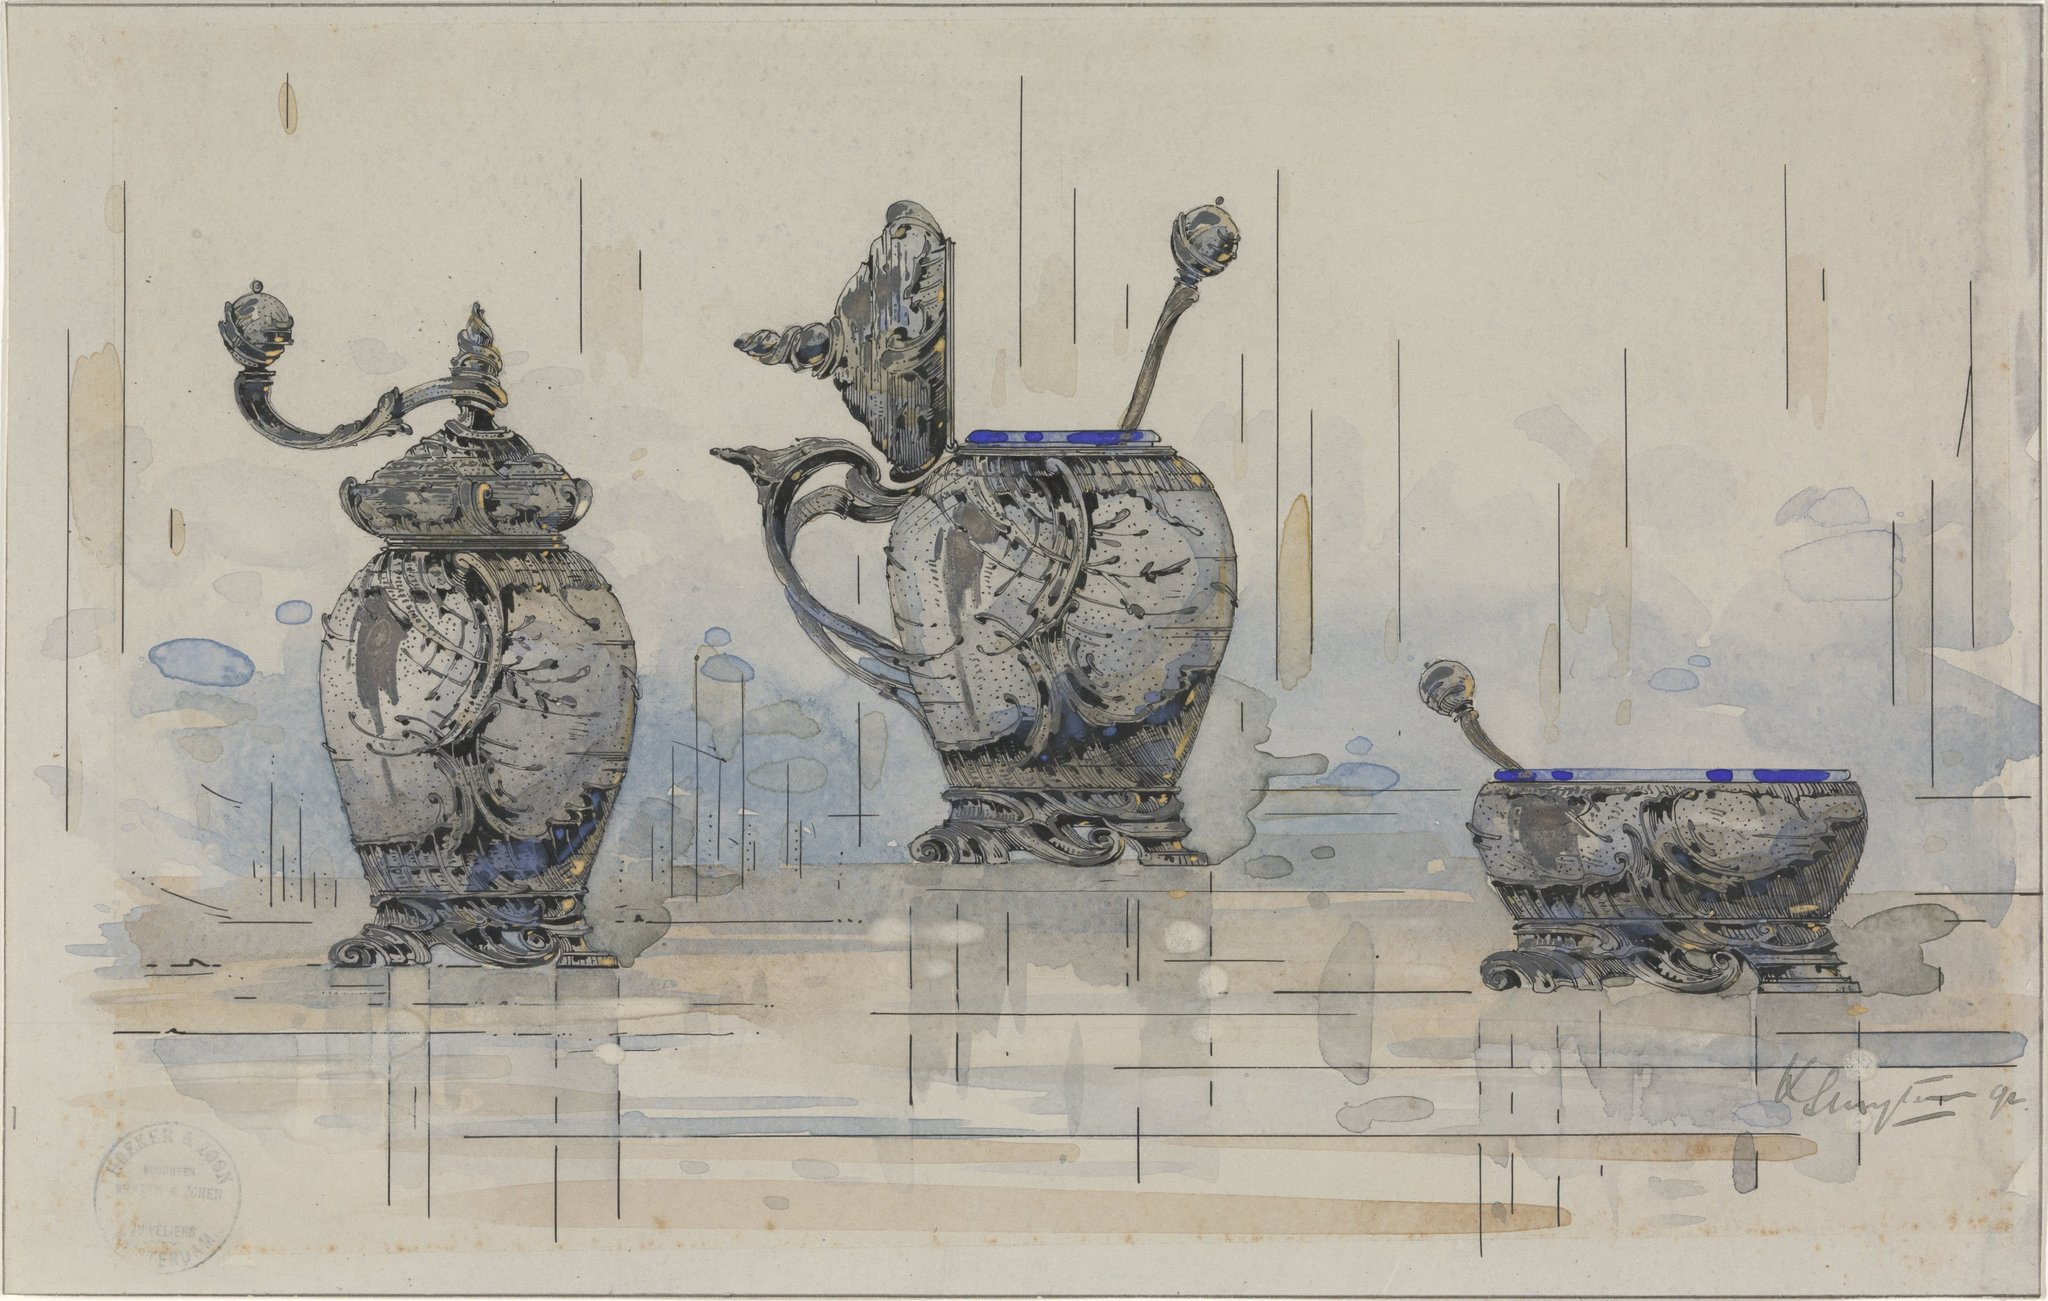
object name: design drawing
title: Ontwerp voor een pepermolen, een mosterdpot en een zoutvat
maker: karel sluijterman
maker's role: designer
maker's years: 1863-1931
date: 1892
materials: ink, paint, paper, watercolor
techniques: brush, pen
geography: amsterdam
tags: spice-box, salt-cellar, salt-shaker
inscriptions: signature and date: ‘K Sluyterman 92’, stamp: ‘onder: HOEKER & ZOON / VOORHEEN / BENTEN & ZONEN / JUWELIERS / AMSTERDAM’